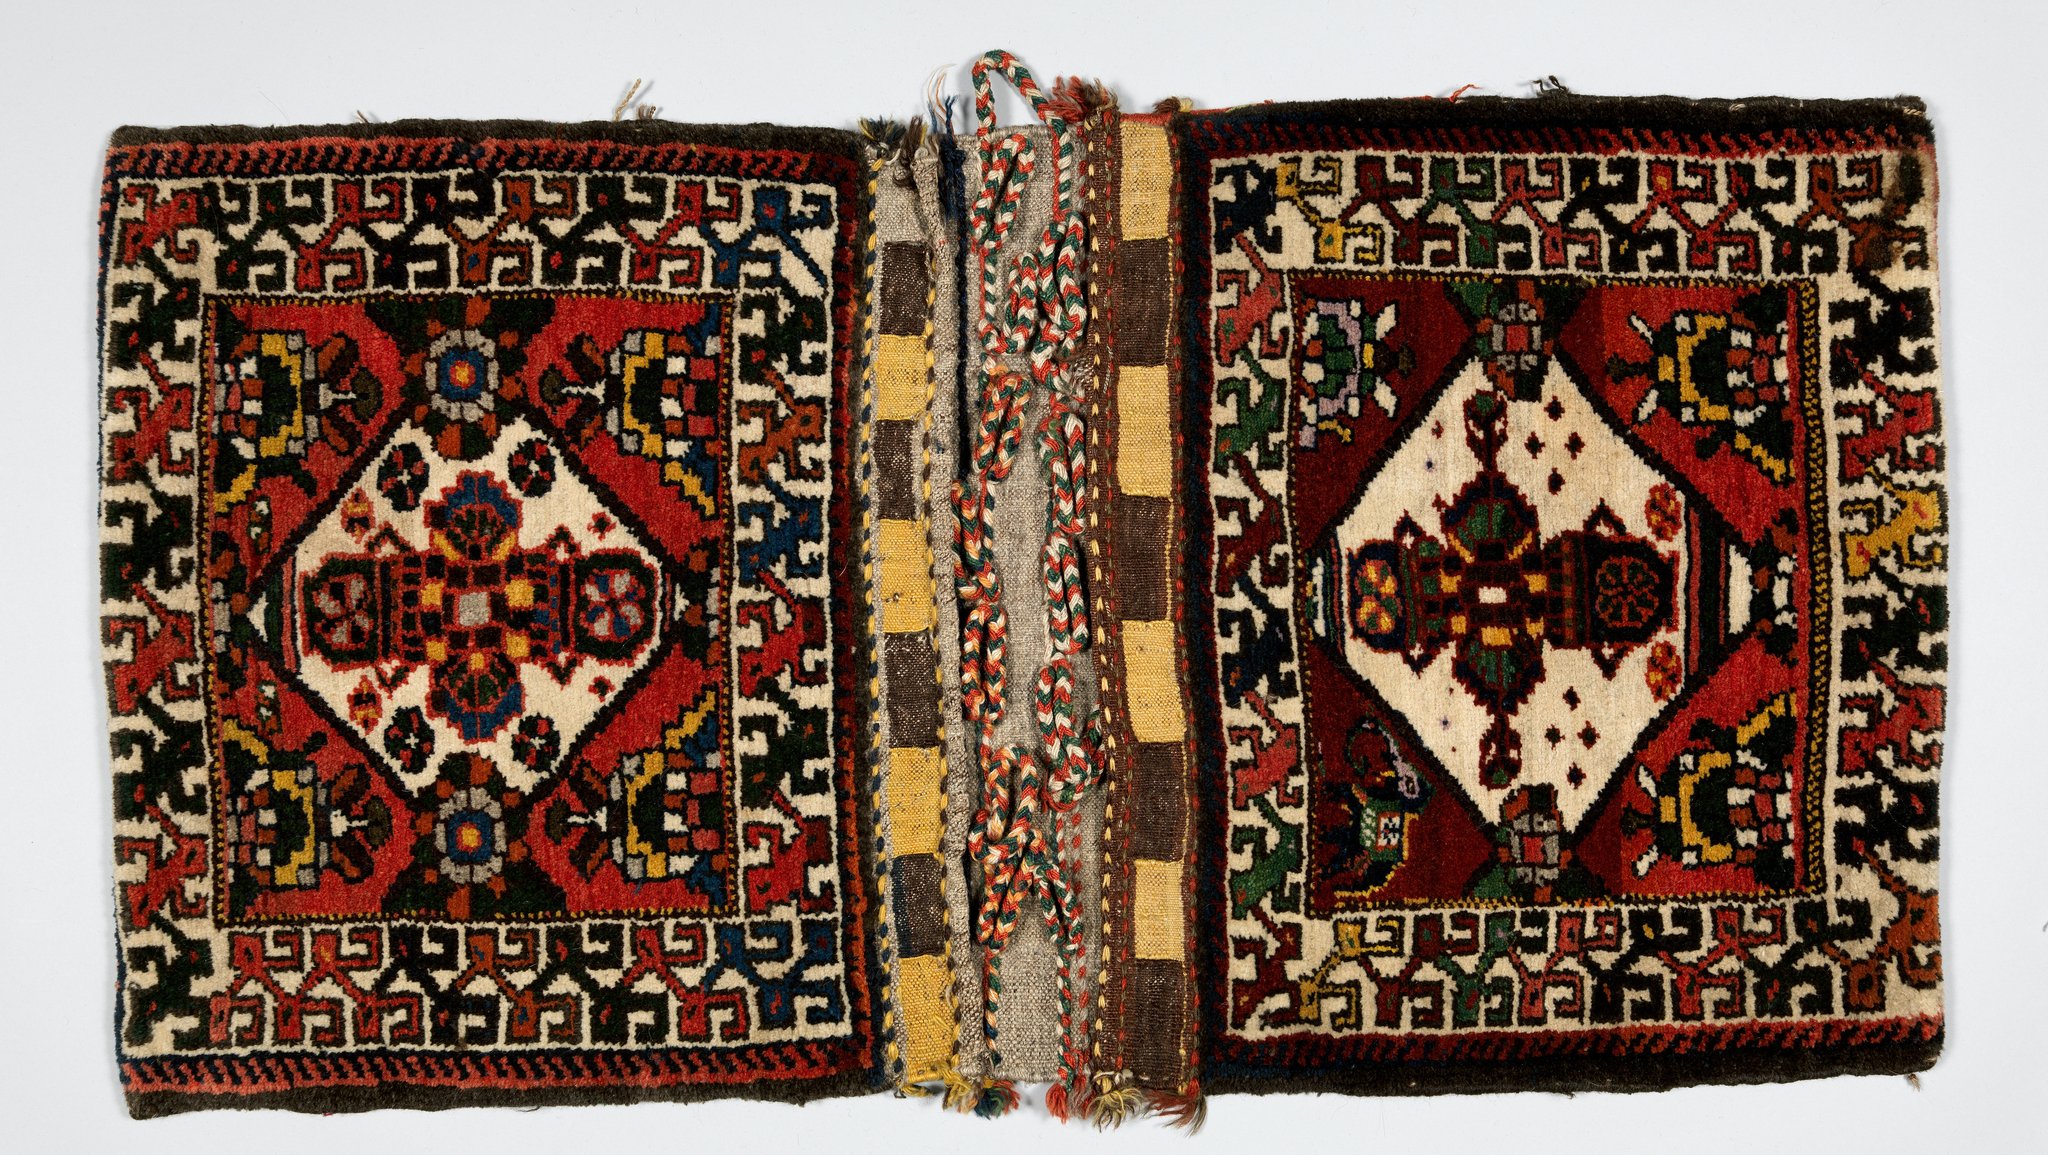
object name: saddle bag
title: Double Saddle Bag (Khorjin)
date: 1900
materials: wool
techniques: weave, slit, pile, tapestry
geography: western iran